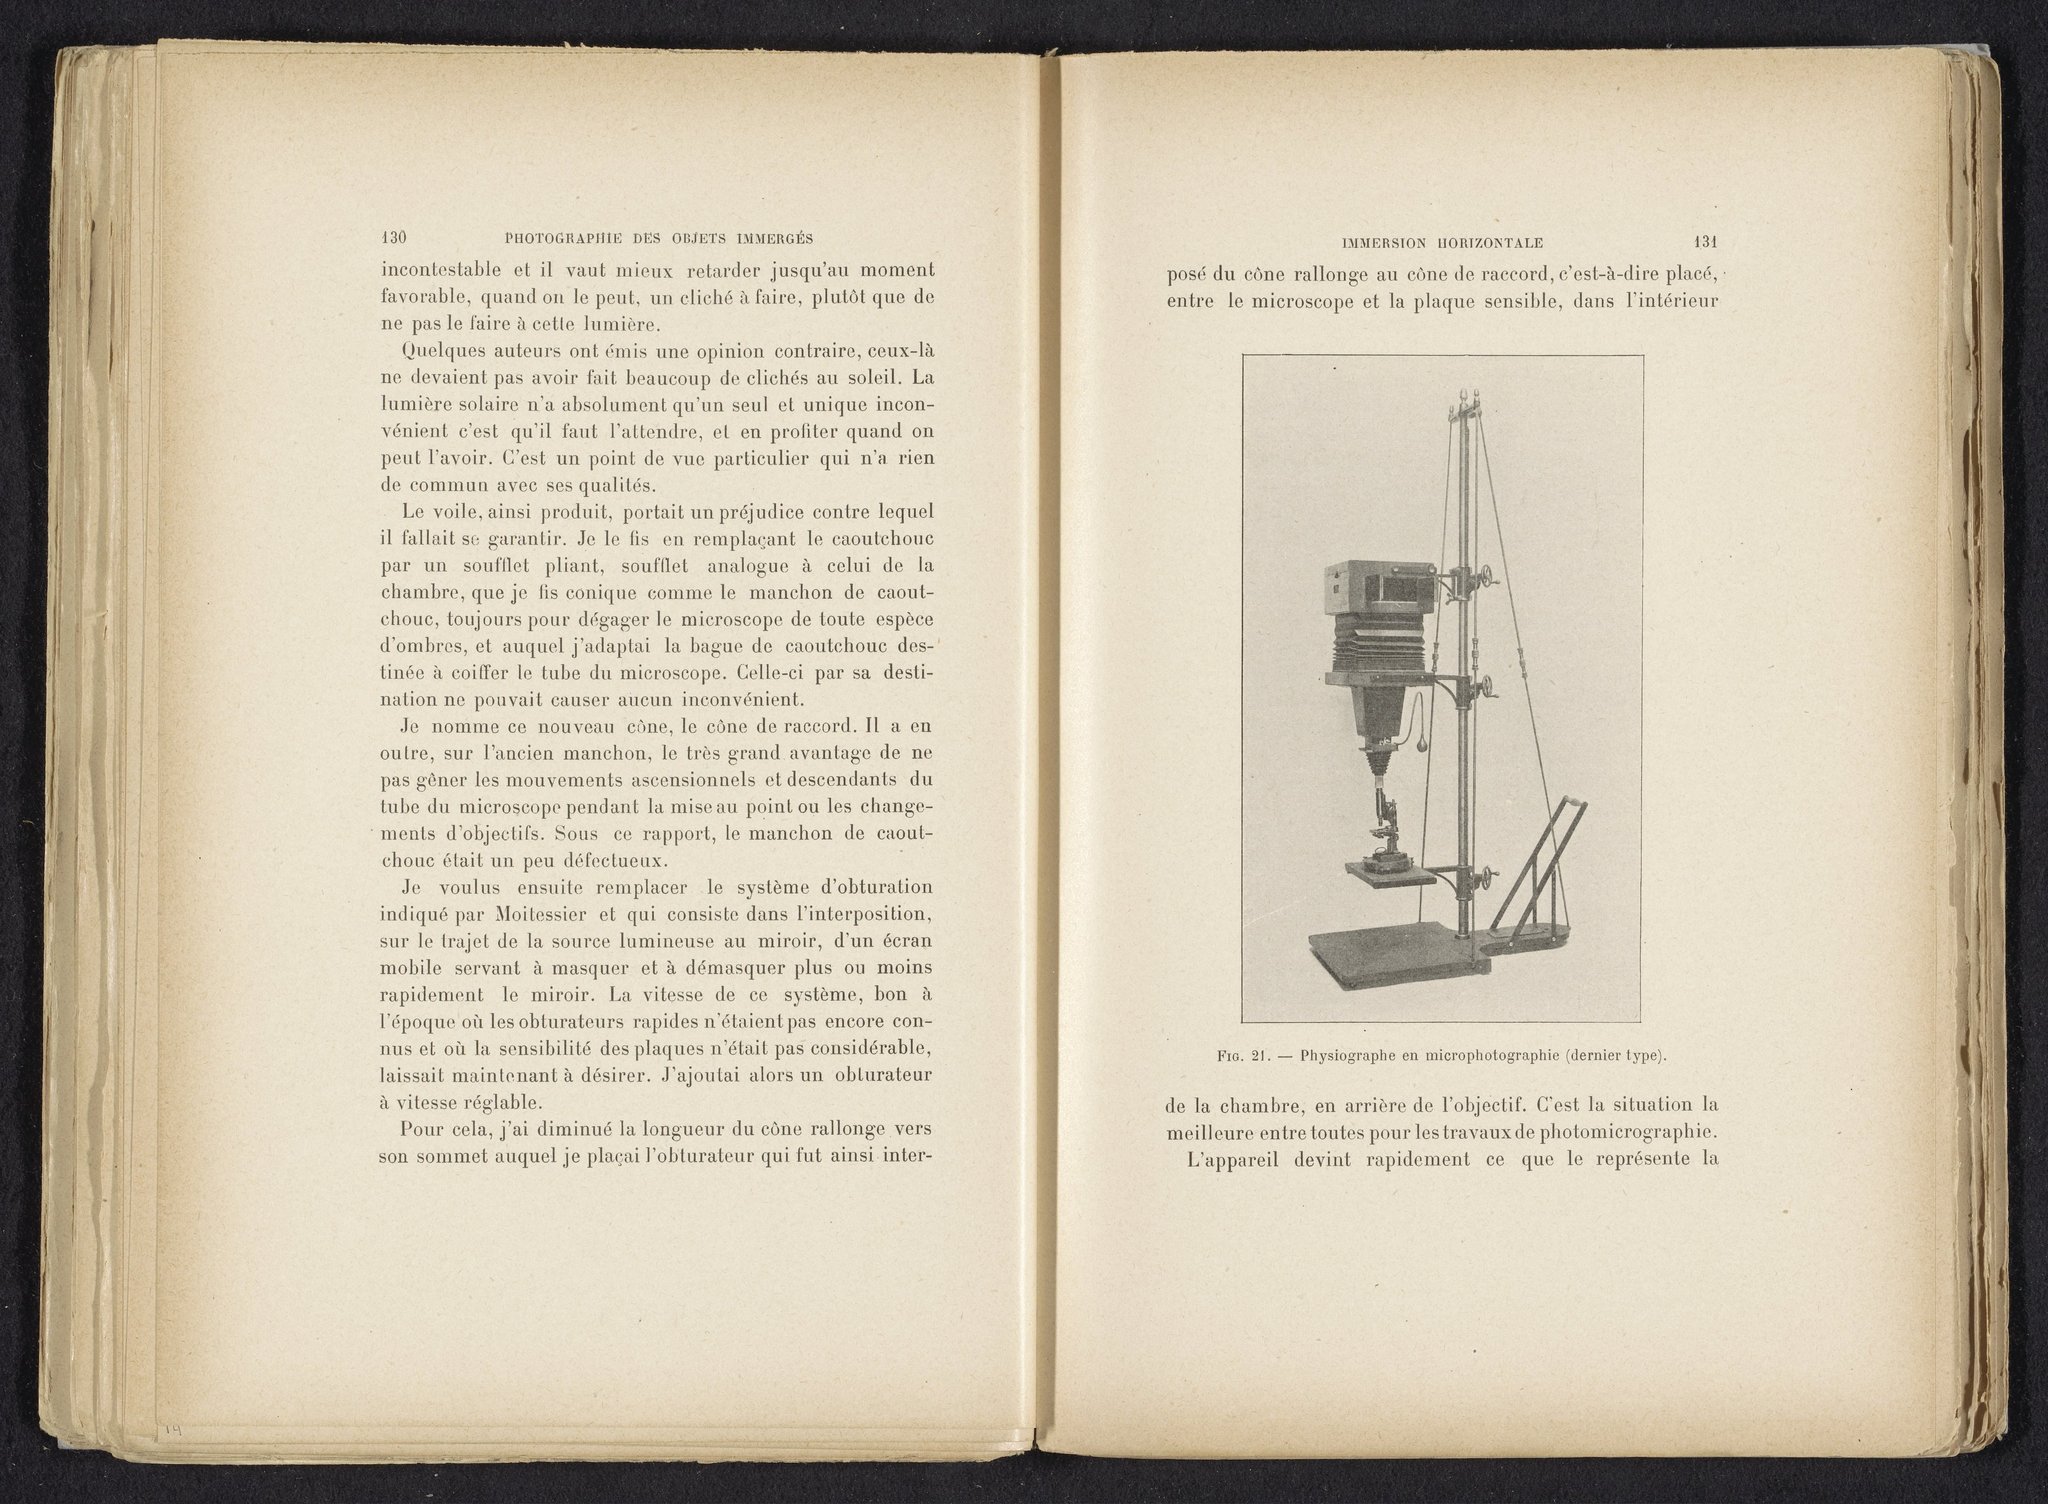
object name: page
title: Physiographe en microphotographie ( dernier type)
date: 1891-1901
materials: paper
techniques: autotype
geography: paris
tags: photographic apparatus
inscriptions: number: ‘Fig. 21.’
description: Prent in album 'La photographie des objets immergés', 1901.